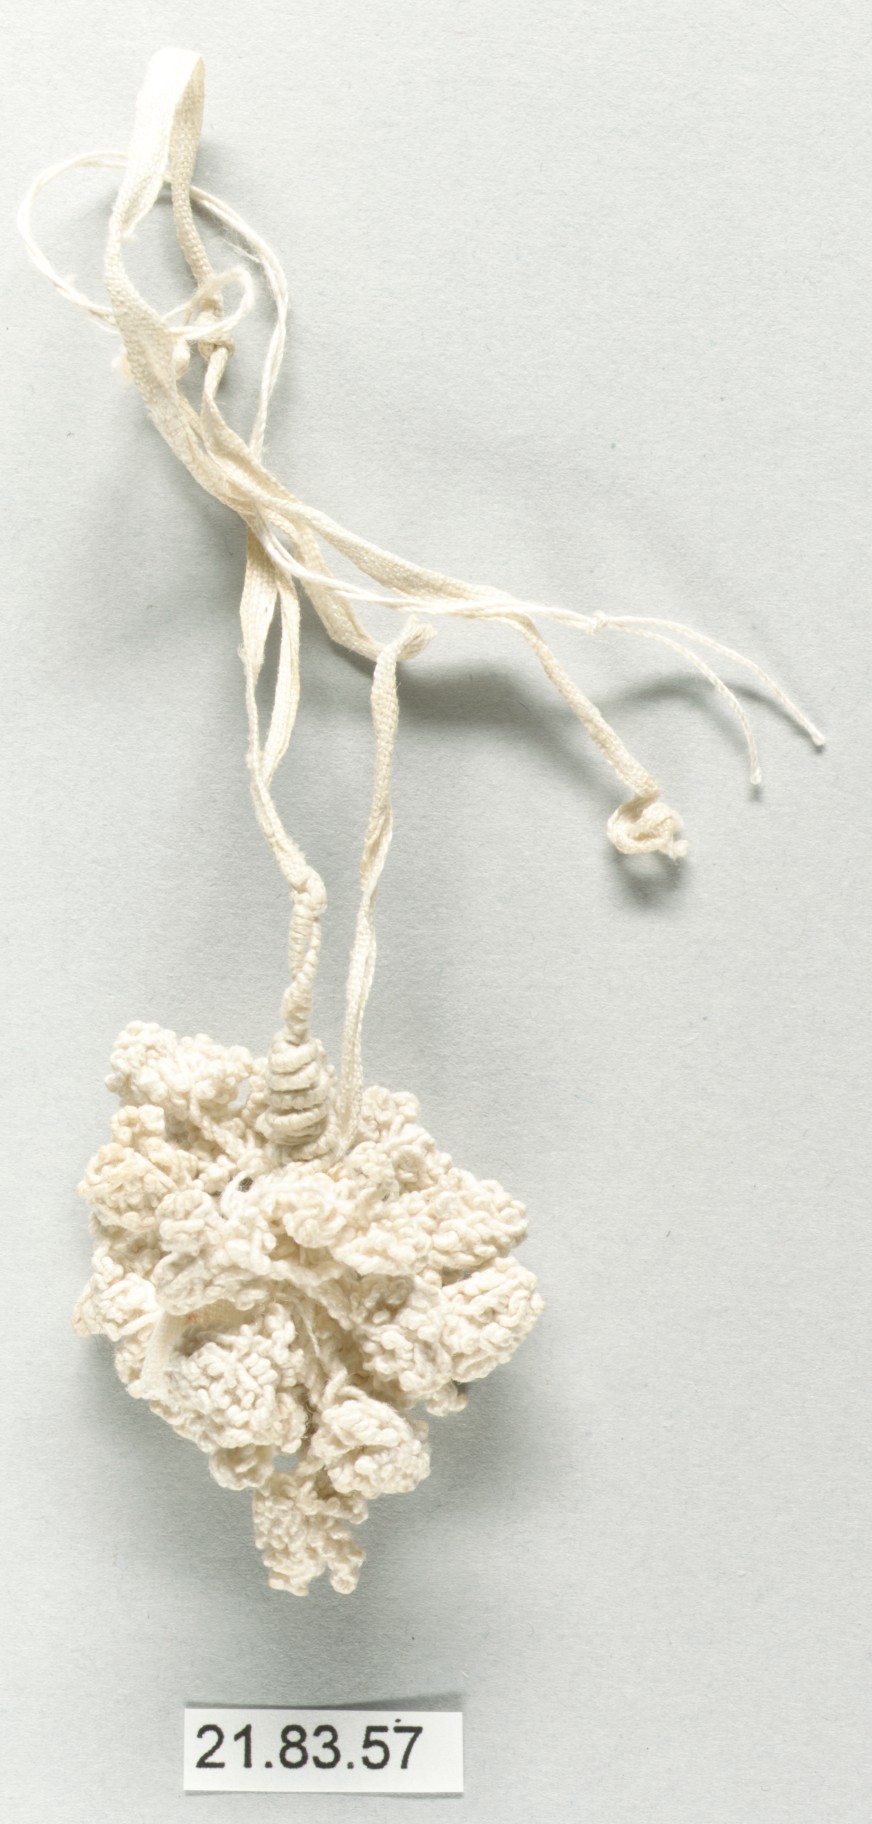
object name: tassel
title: Pair of tassels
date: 1601-1700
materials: linen